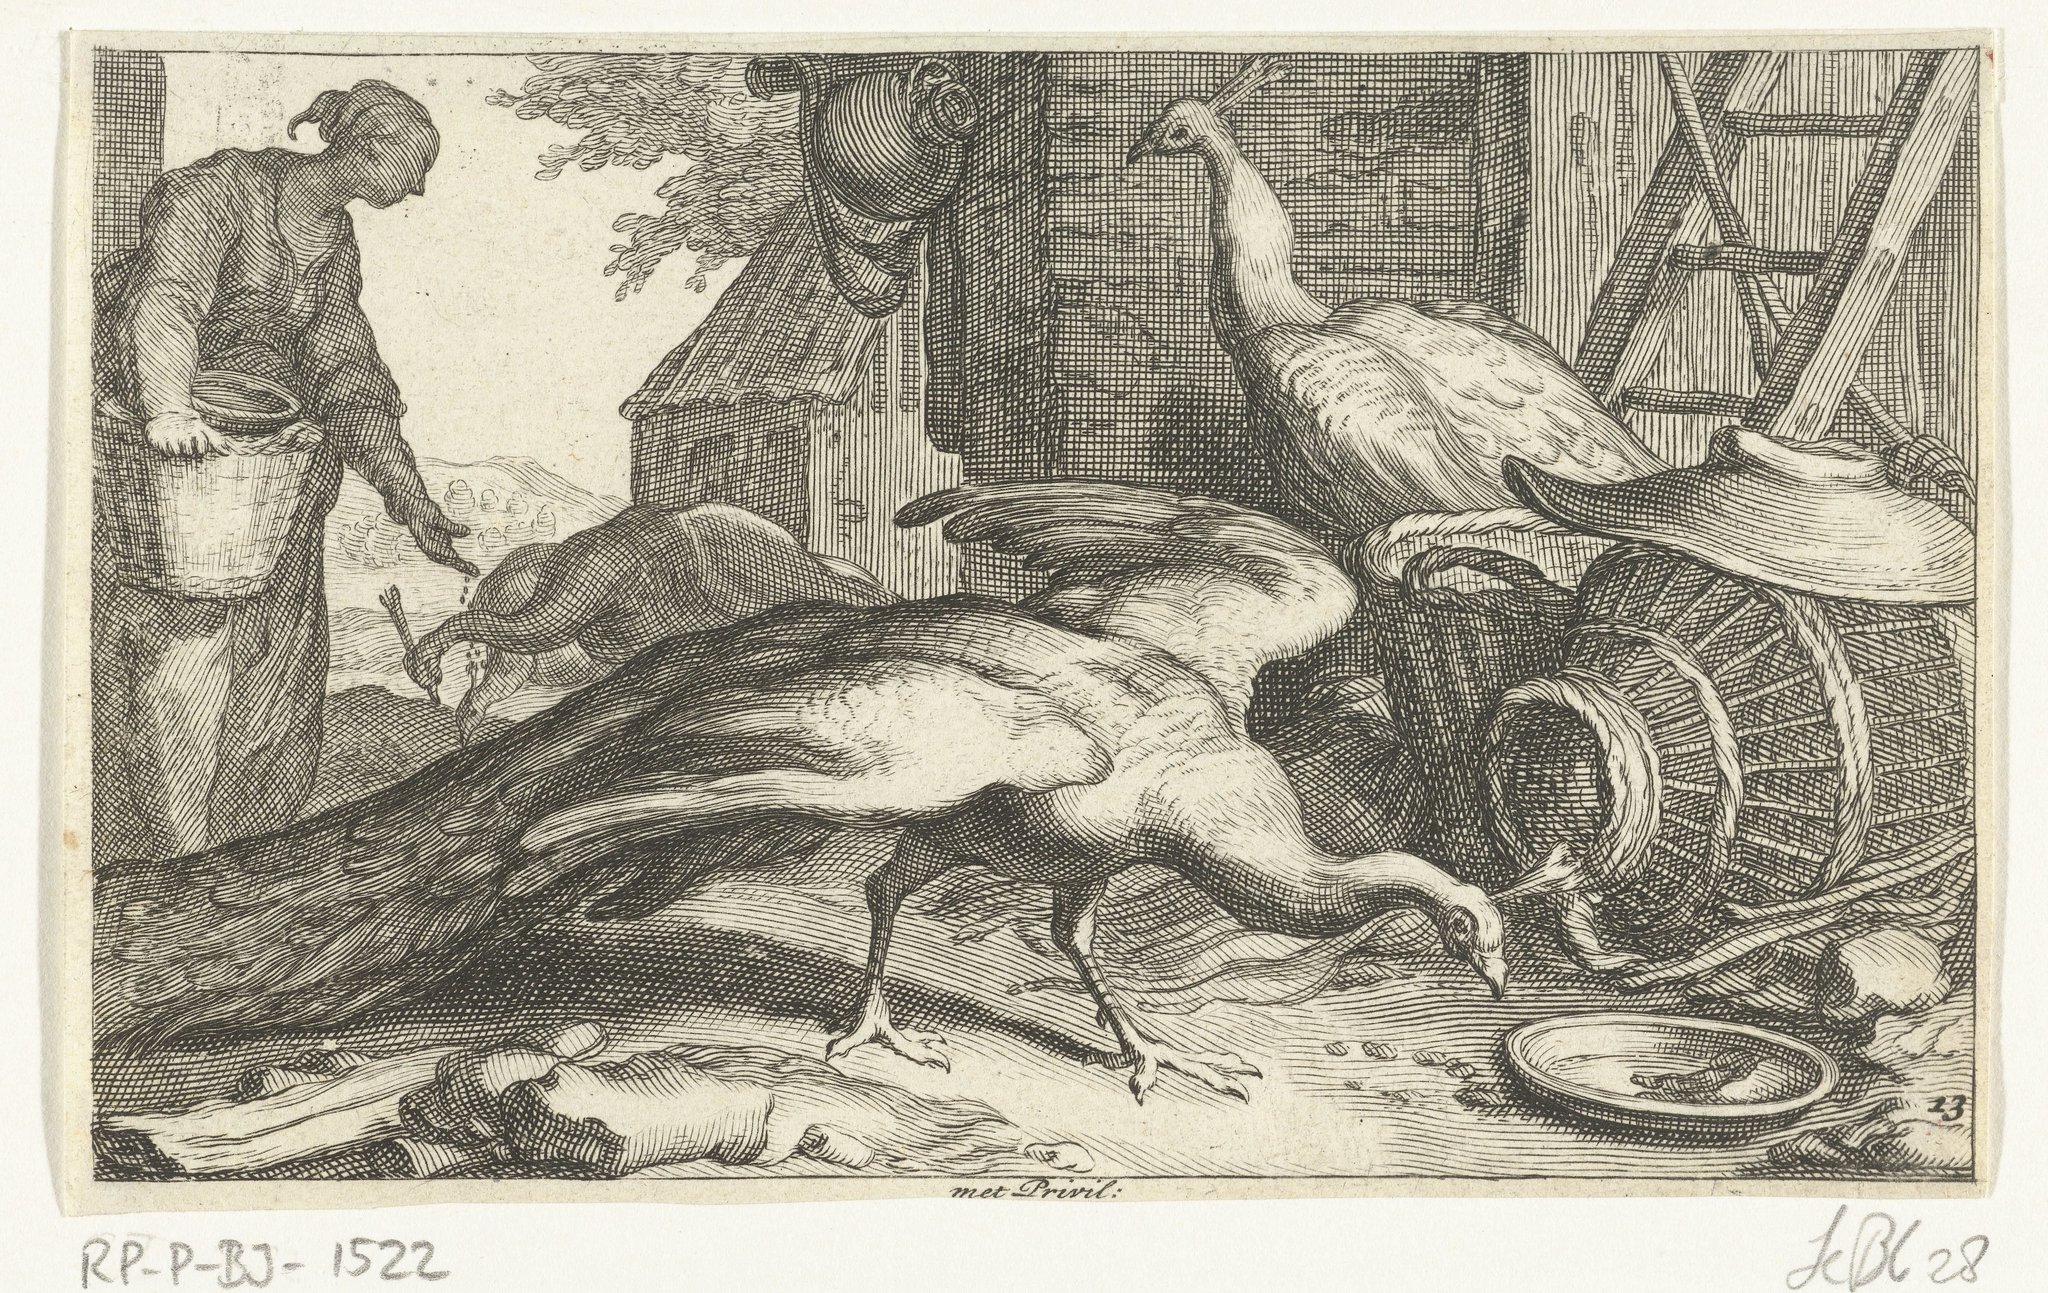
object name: print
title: Dieren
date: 1635-1670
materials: paper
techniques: engraving, etching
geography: utrecht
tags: ornamental birds: peacock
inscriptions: collector's mark: Lugt 240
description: Een maagd voert pauwen die rond lopen op een boerenerf. Prent uit een serie van 14 prenten met verschillende inheemse dieren.